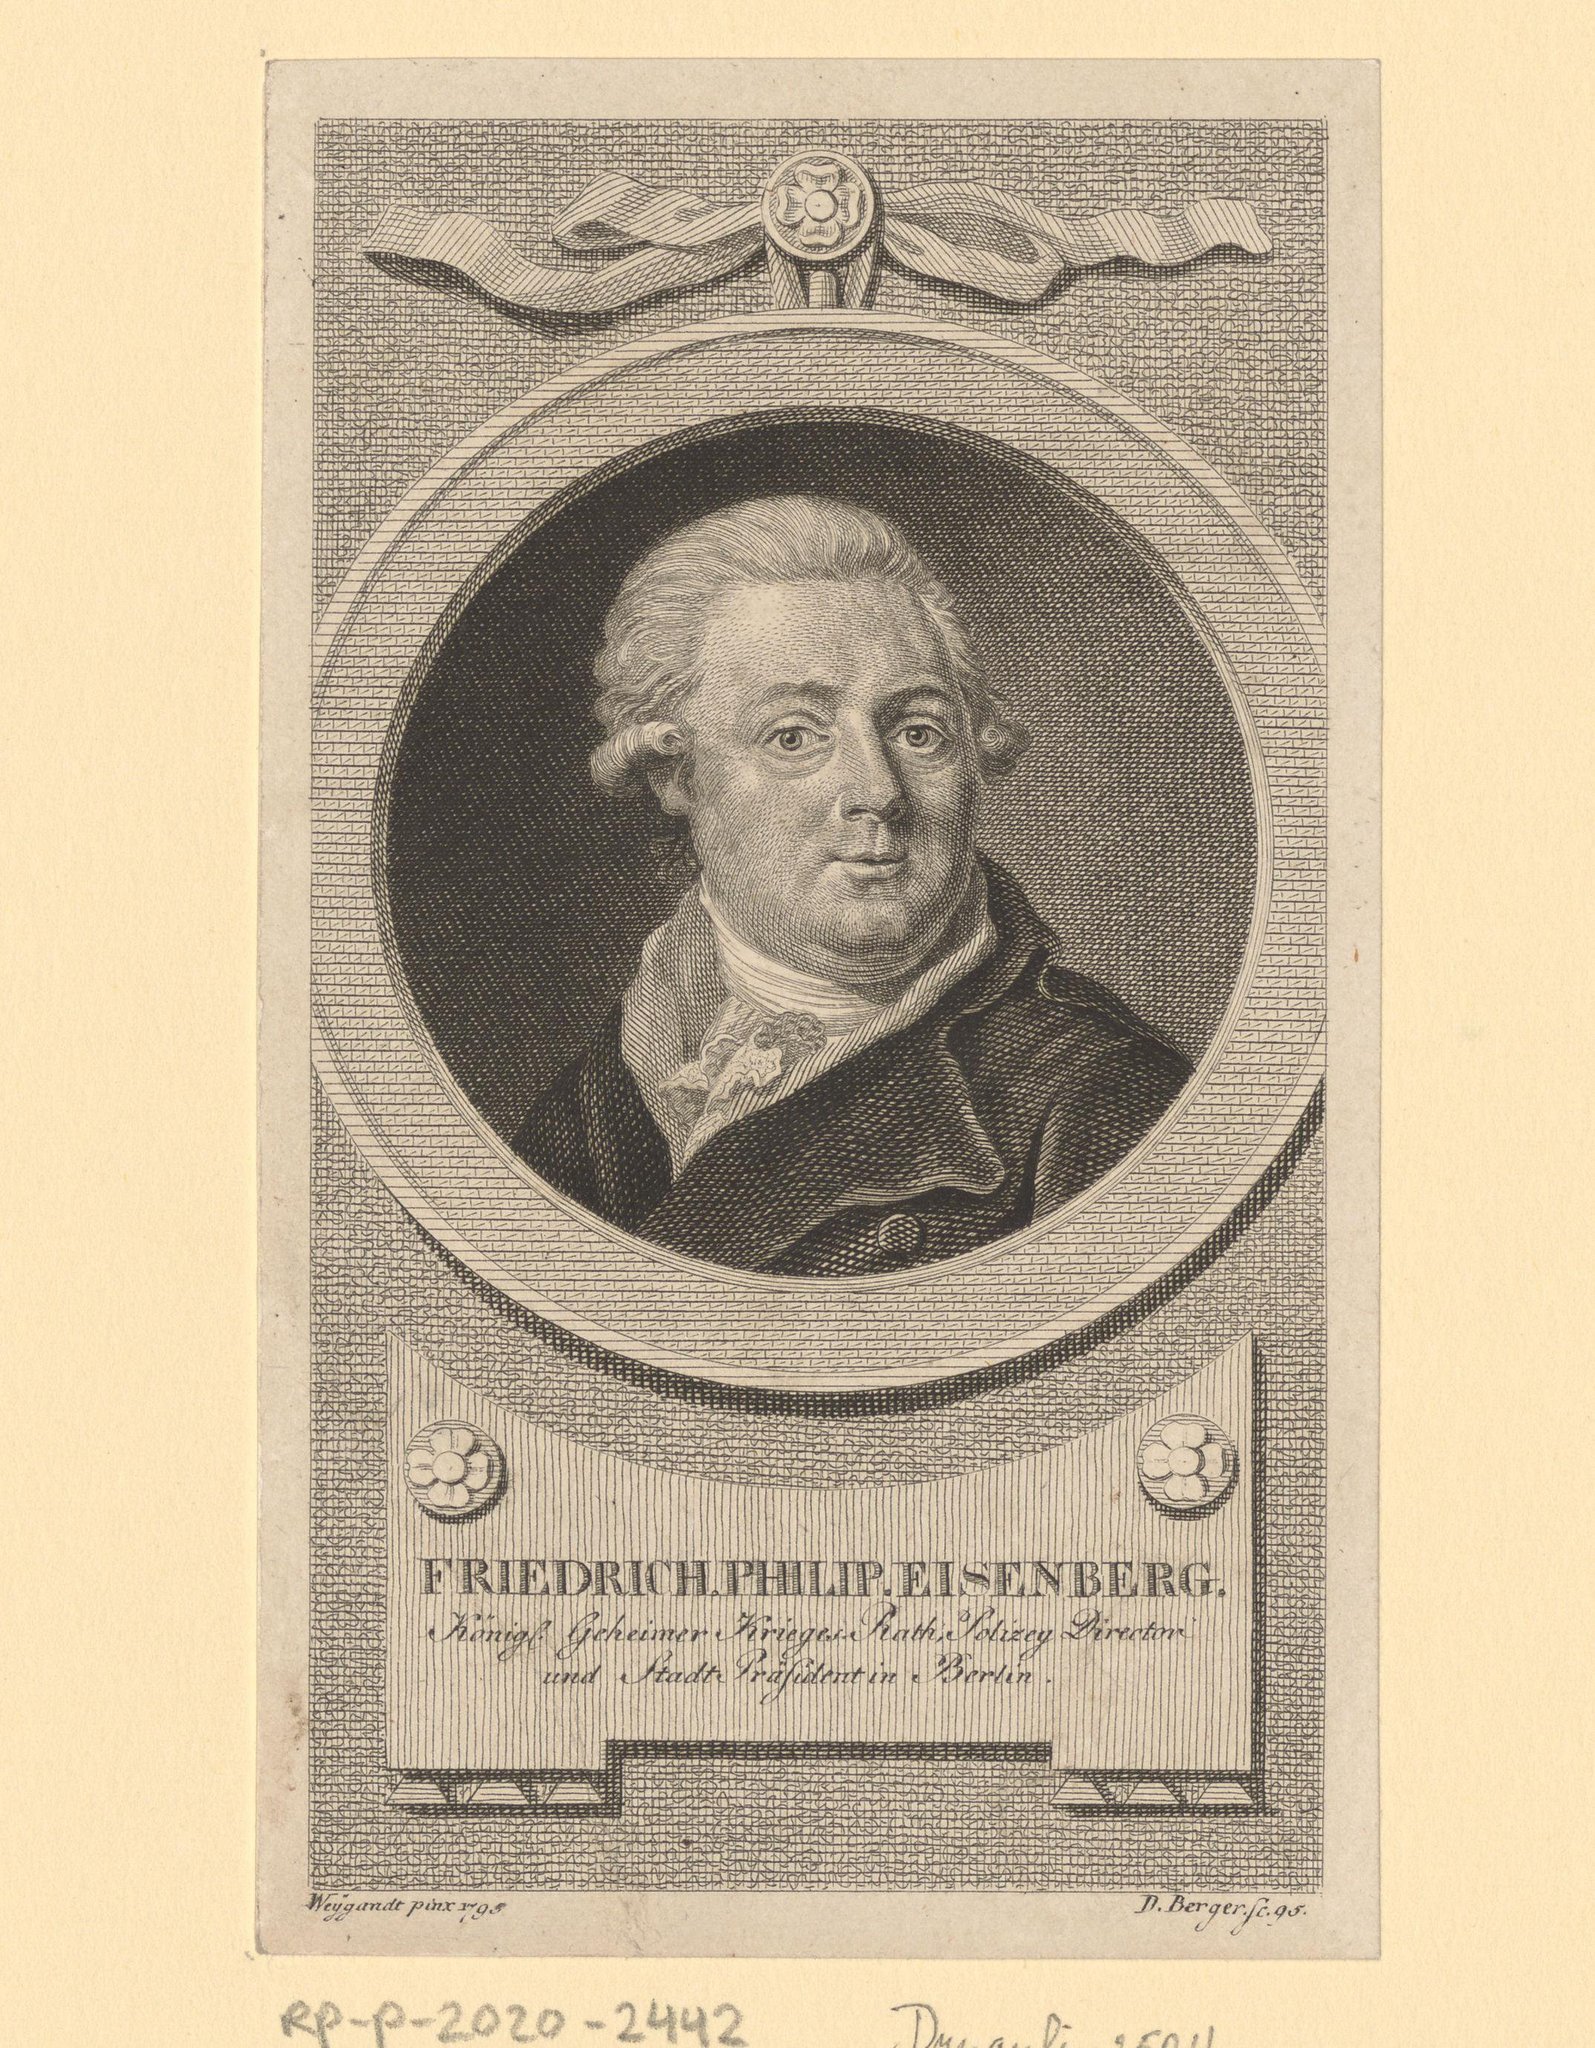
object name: print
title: Portret van Friedrich Philipp von Eisenberg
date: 1795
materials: paper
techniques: engraving, etching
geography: berlin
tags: politician, historical persons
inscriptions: date